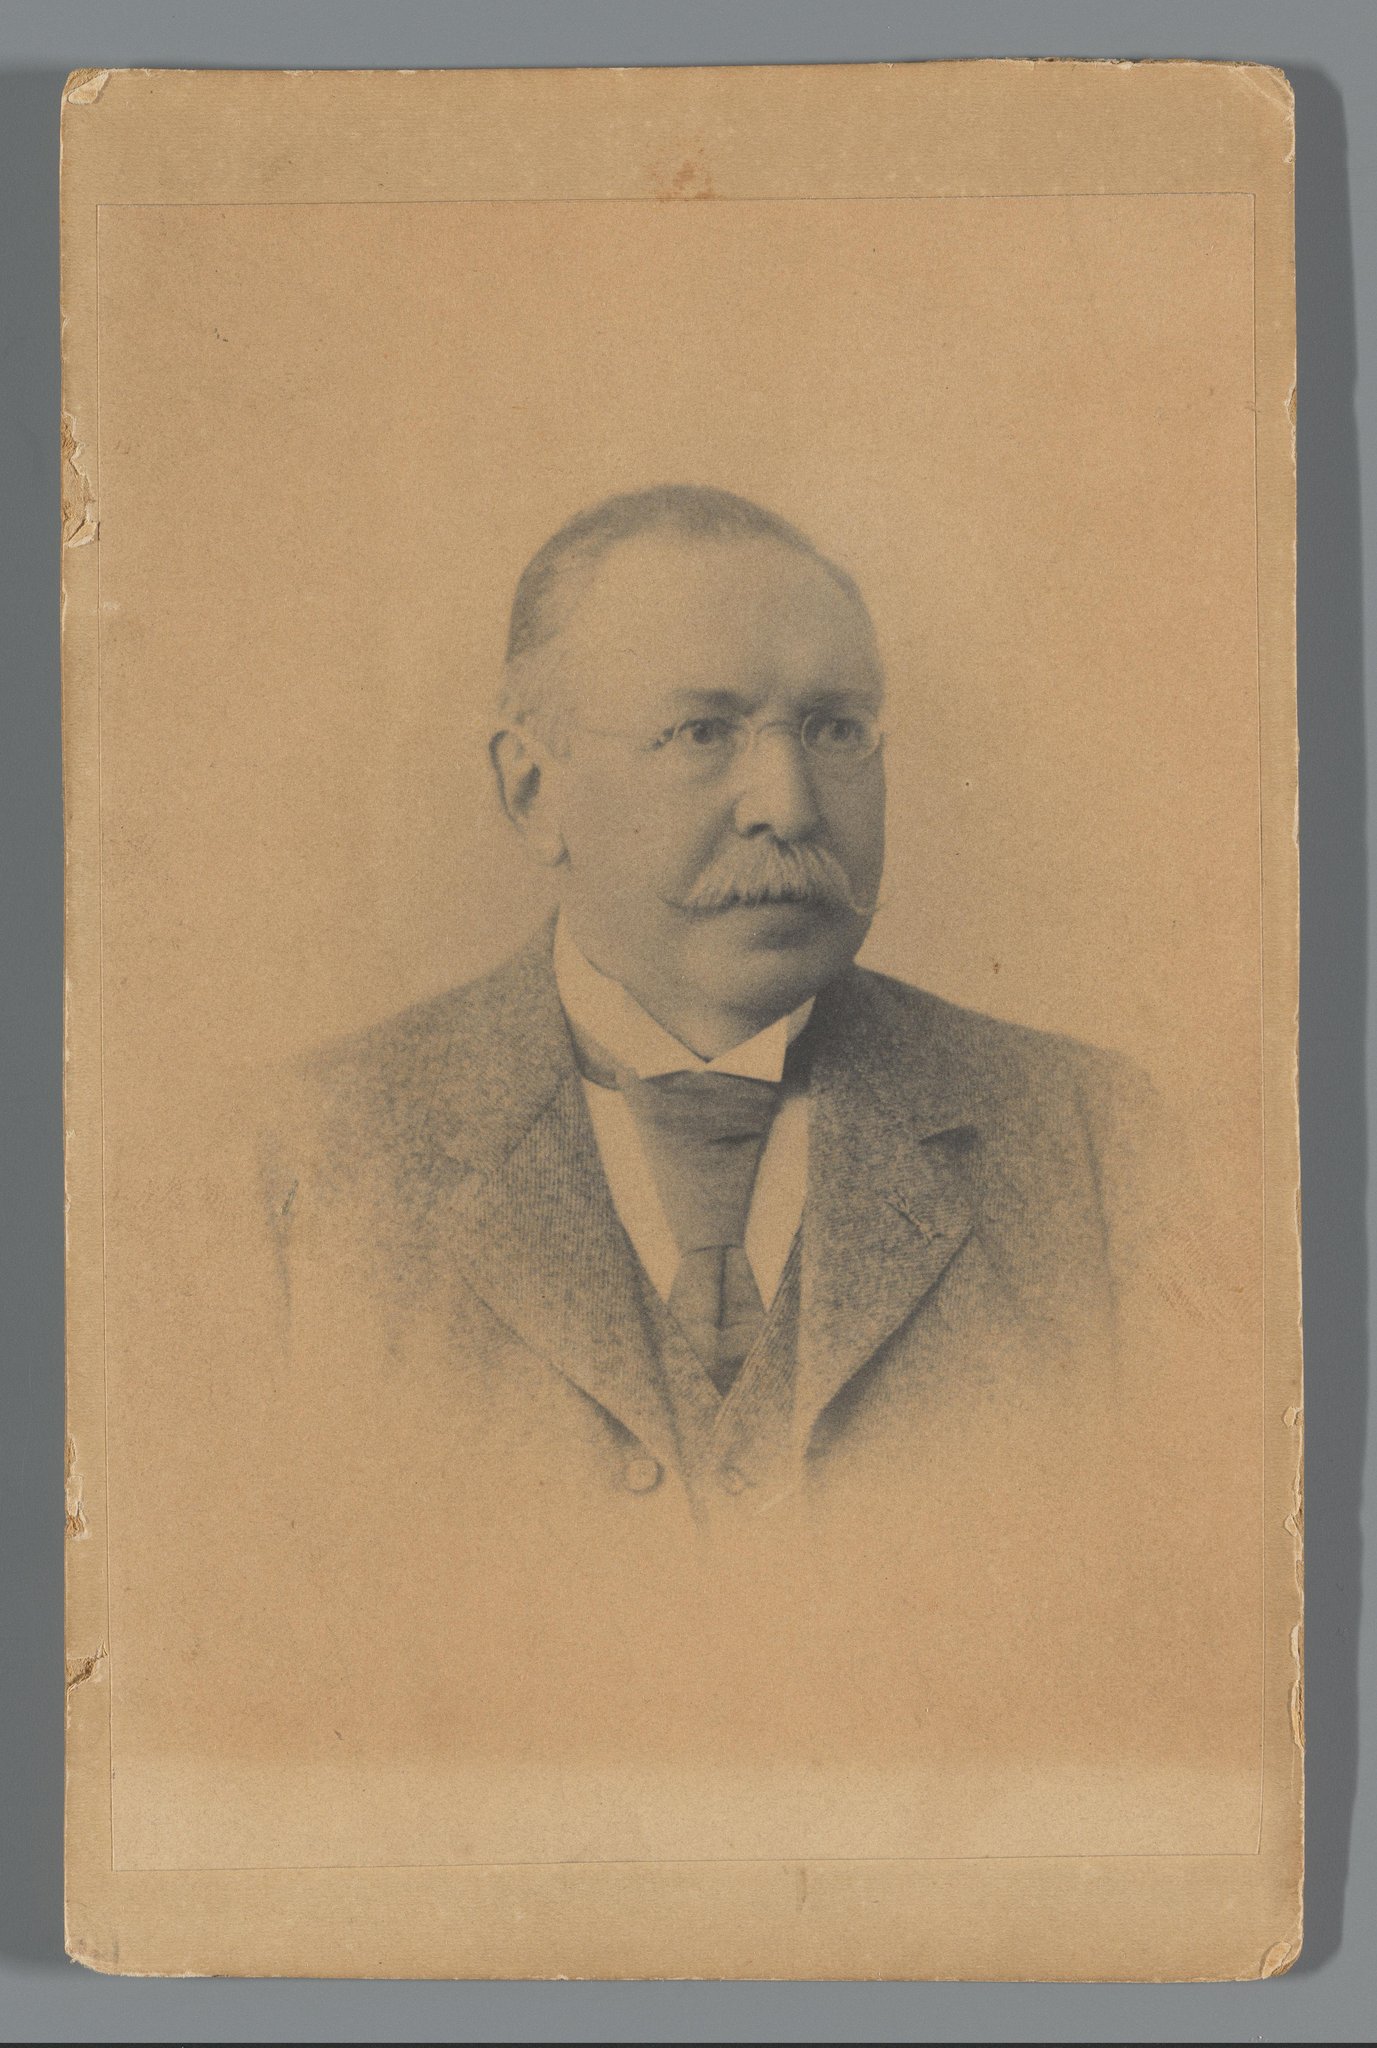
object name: photograph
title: Portret van Norbert van den Berg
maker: franz baum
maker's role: fotograaf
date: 1880-1910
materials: photographic support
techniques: albumen print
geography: london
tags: rotterdam, amsterdam, norbertus petrus van den berg (1831-1917)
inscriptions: inscription: ‘LONDON STUDIO, / 12 OLD BOND ST. W.’, name: ‘Franz Baum’, inscription: ‘STUDIO FOR / Equestrian Portraits & c. / WINTON HOUSE, BOWDON.’